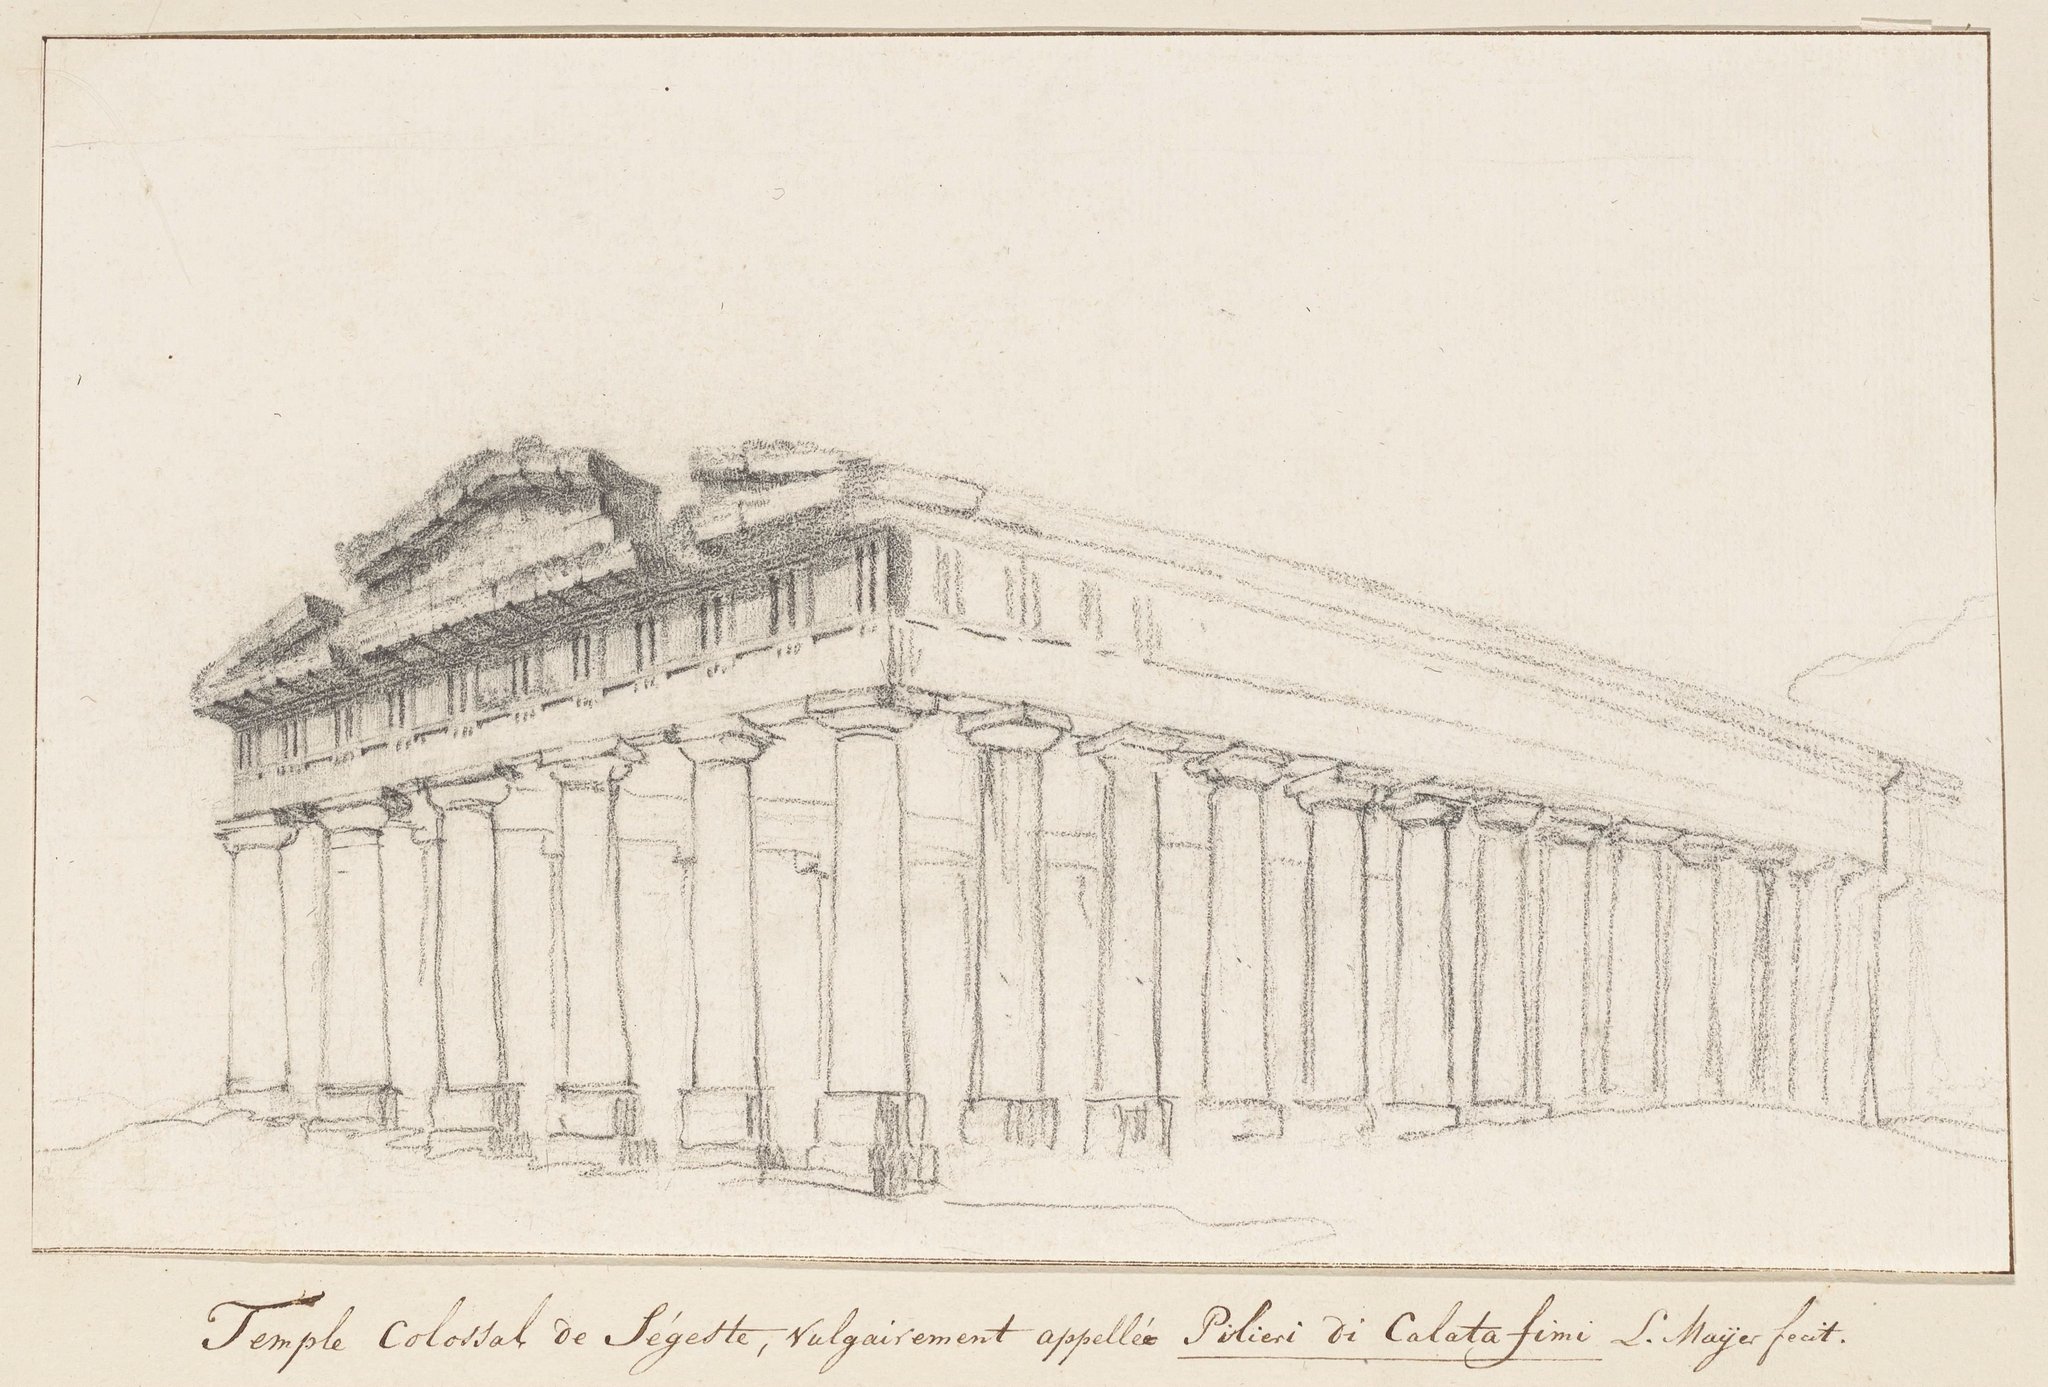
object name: drawing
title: Pianta del' Tempio di Sagesta, chiamato volgarmente, i Pilieri di Calatafimi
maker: louis mayer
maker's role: draughtsman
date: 1778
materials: paper, pencil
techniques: pen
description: Tekening uit het album 'Voyage en Italie, en Sicile et à Malte', 1778.